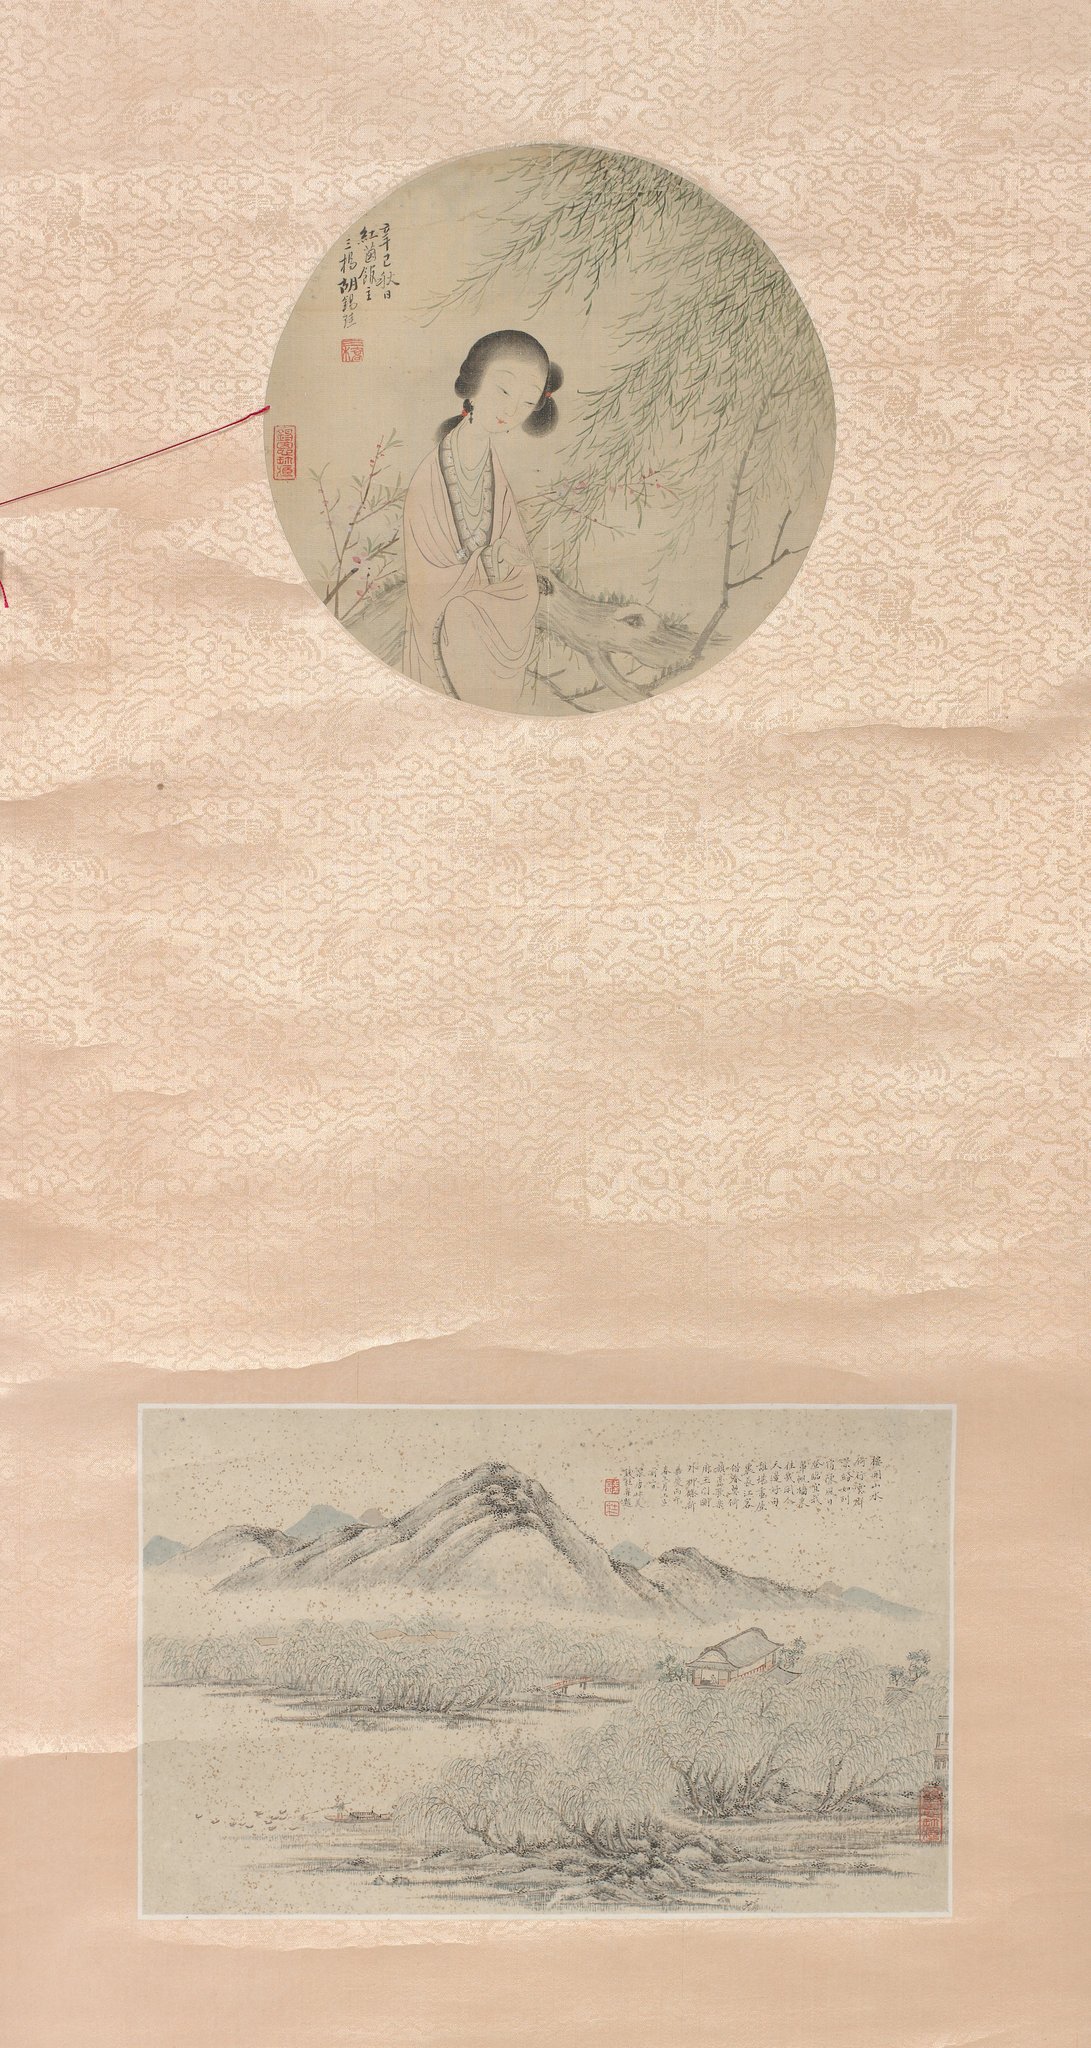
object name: mounted fan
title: Beautiful lady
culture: chinese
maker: hu xigui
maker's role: artist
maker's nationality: chinese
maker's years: 1839-1883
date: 1881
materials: ink, silk